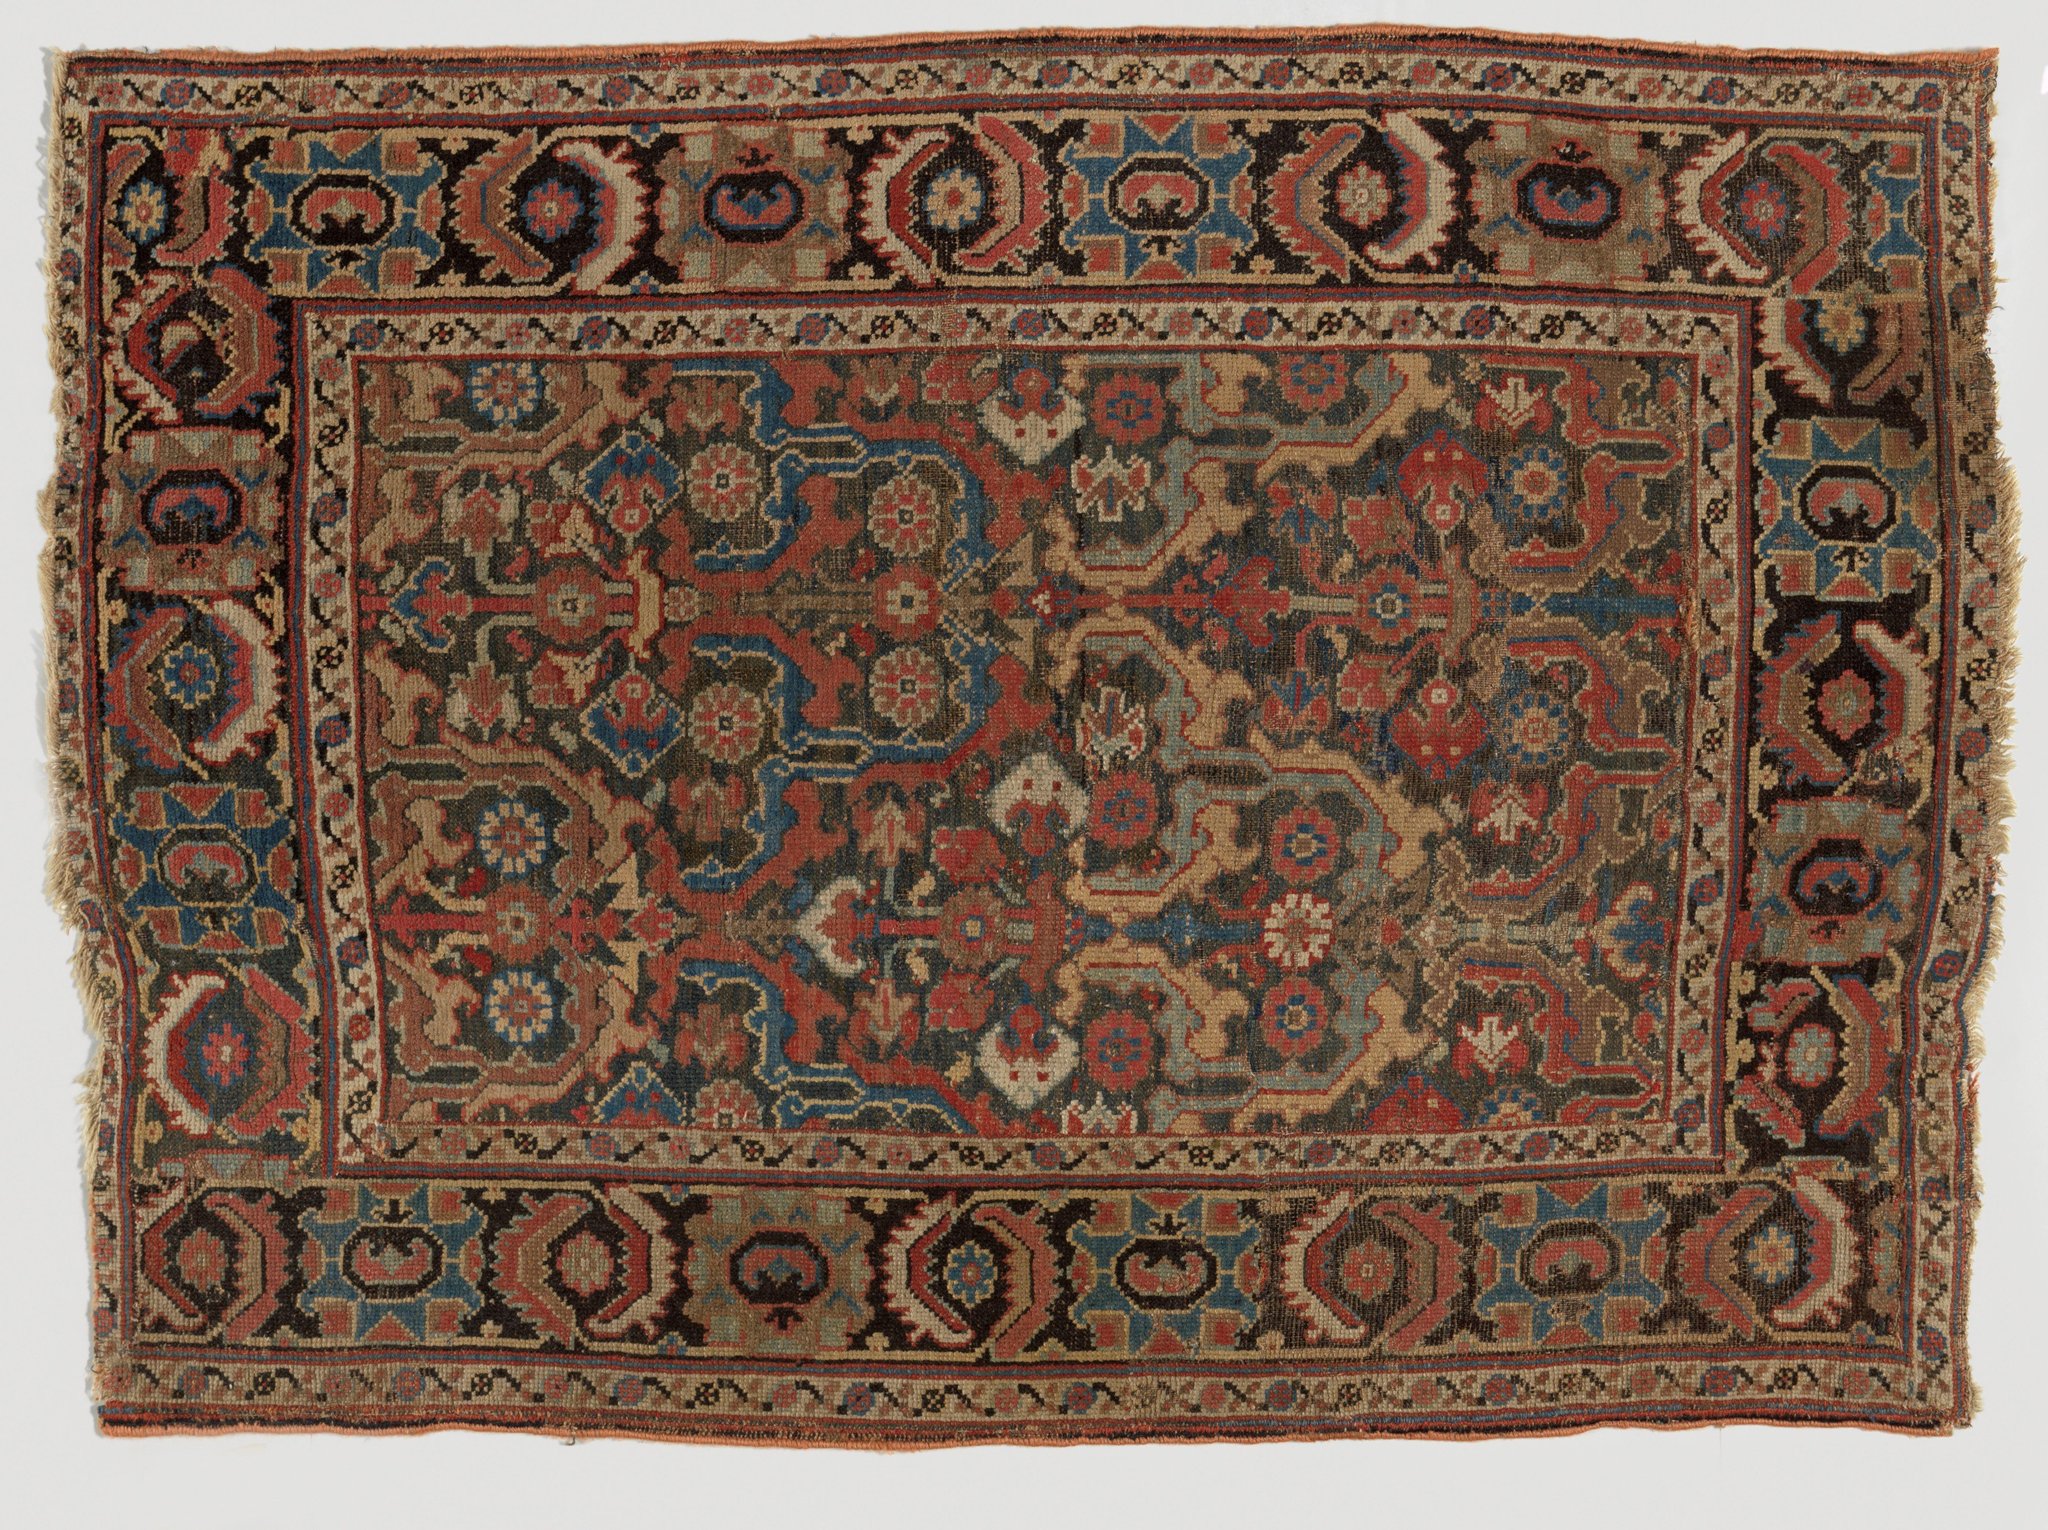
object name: oriental rug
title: Oosters tapijt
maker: Anonymous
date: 1800-1900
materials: wool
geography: ferahan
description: Oosters tapijt, bloemenkleed. In het middenveld omega-vormige arabesken en bloemen tegen een bruinzwarte achtergrond. Drievoudige rand, waarvan de middelste met palmetbloemen.